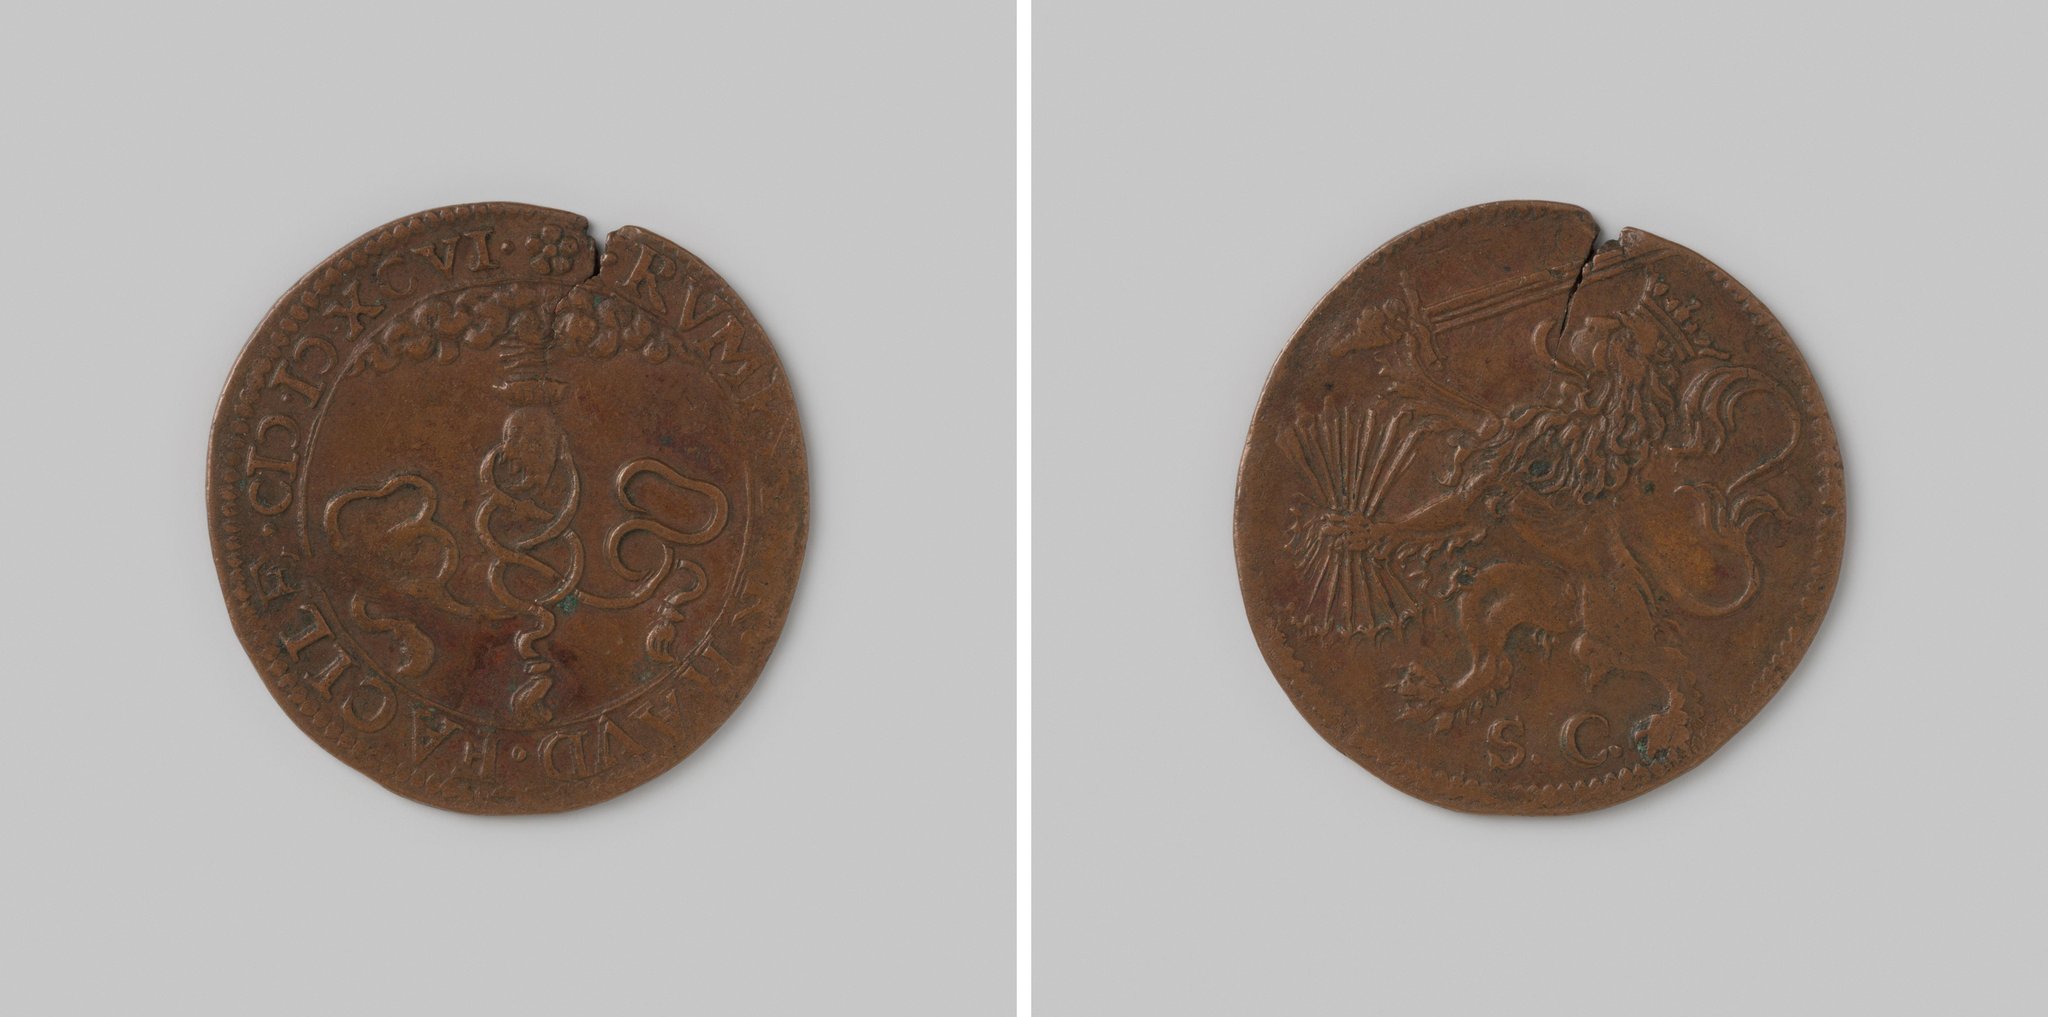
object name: history medal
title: Rekenpenning uit Dordrecht op het Drievoudig Verbond tussen Frankrijk Engeland en Nederland 1596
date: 1596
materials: copper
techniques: striking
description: Koperen penning, op de voorzijde een hand uit de wolken met een koord met drie uiteinden, met omschrift, op de keerzijde een gekroonde klimmende leeuw naar links met zwaard en pijlenbundel, met tekst in het veld.